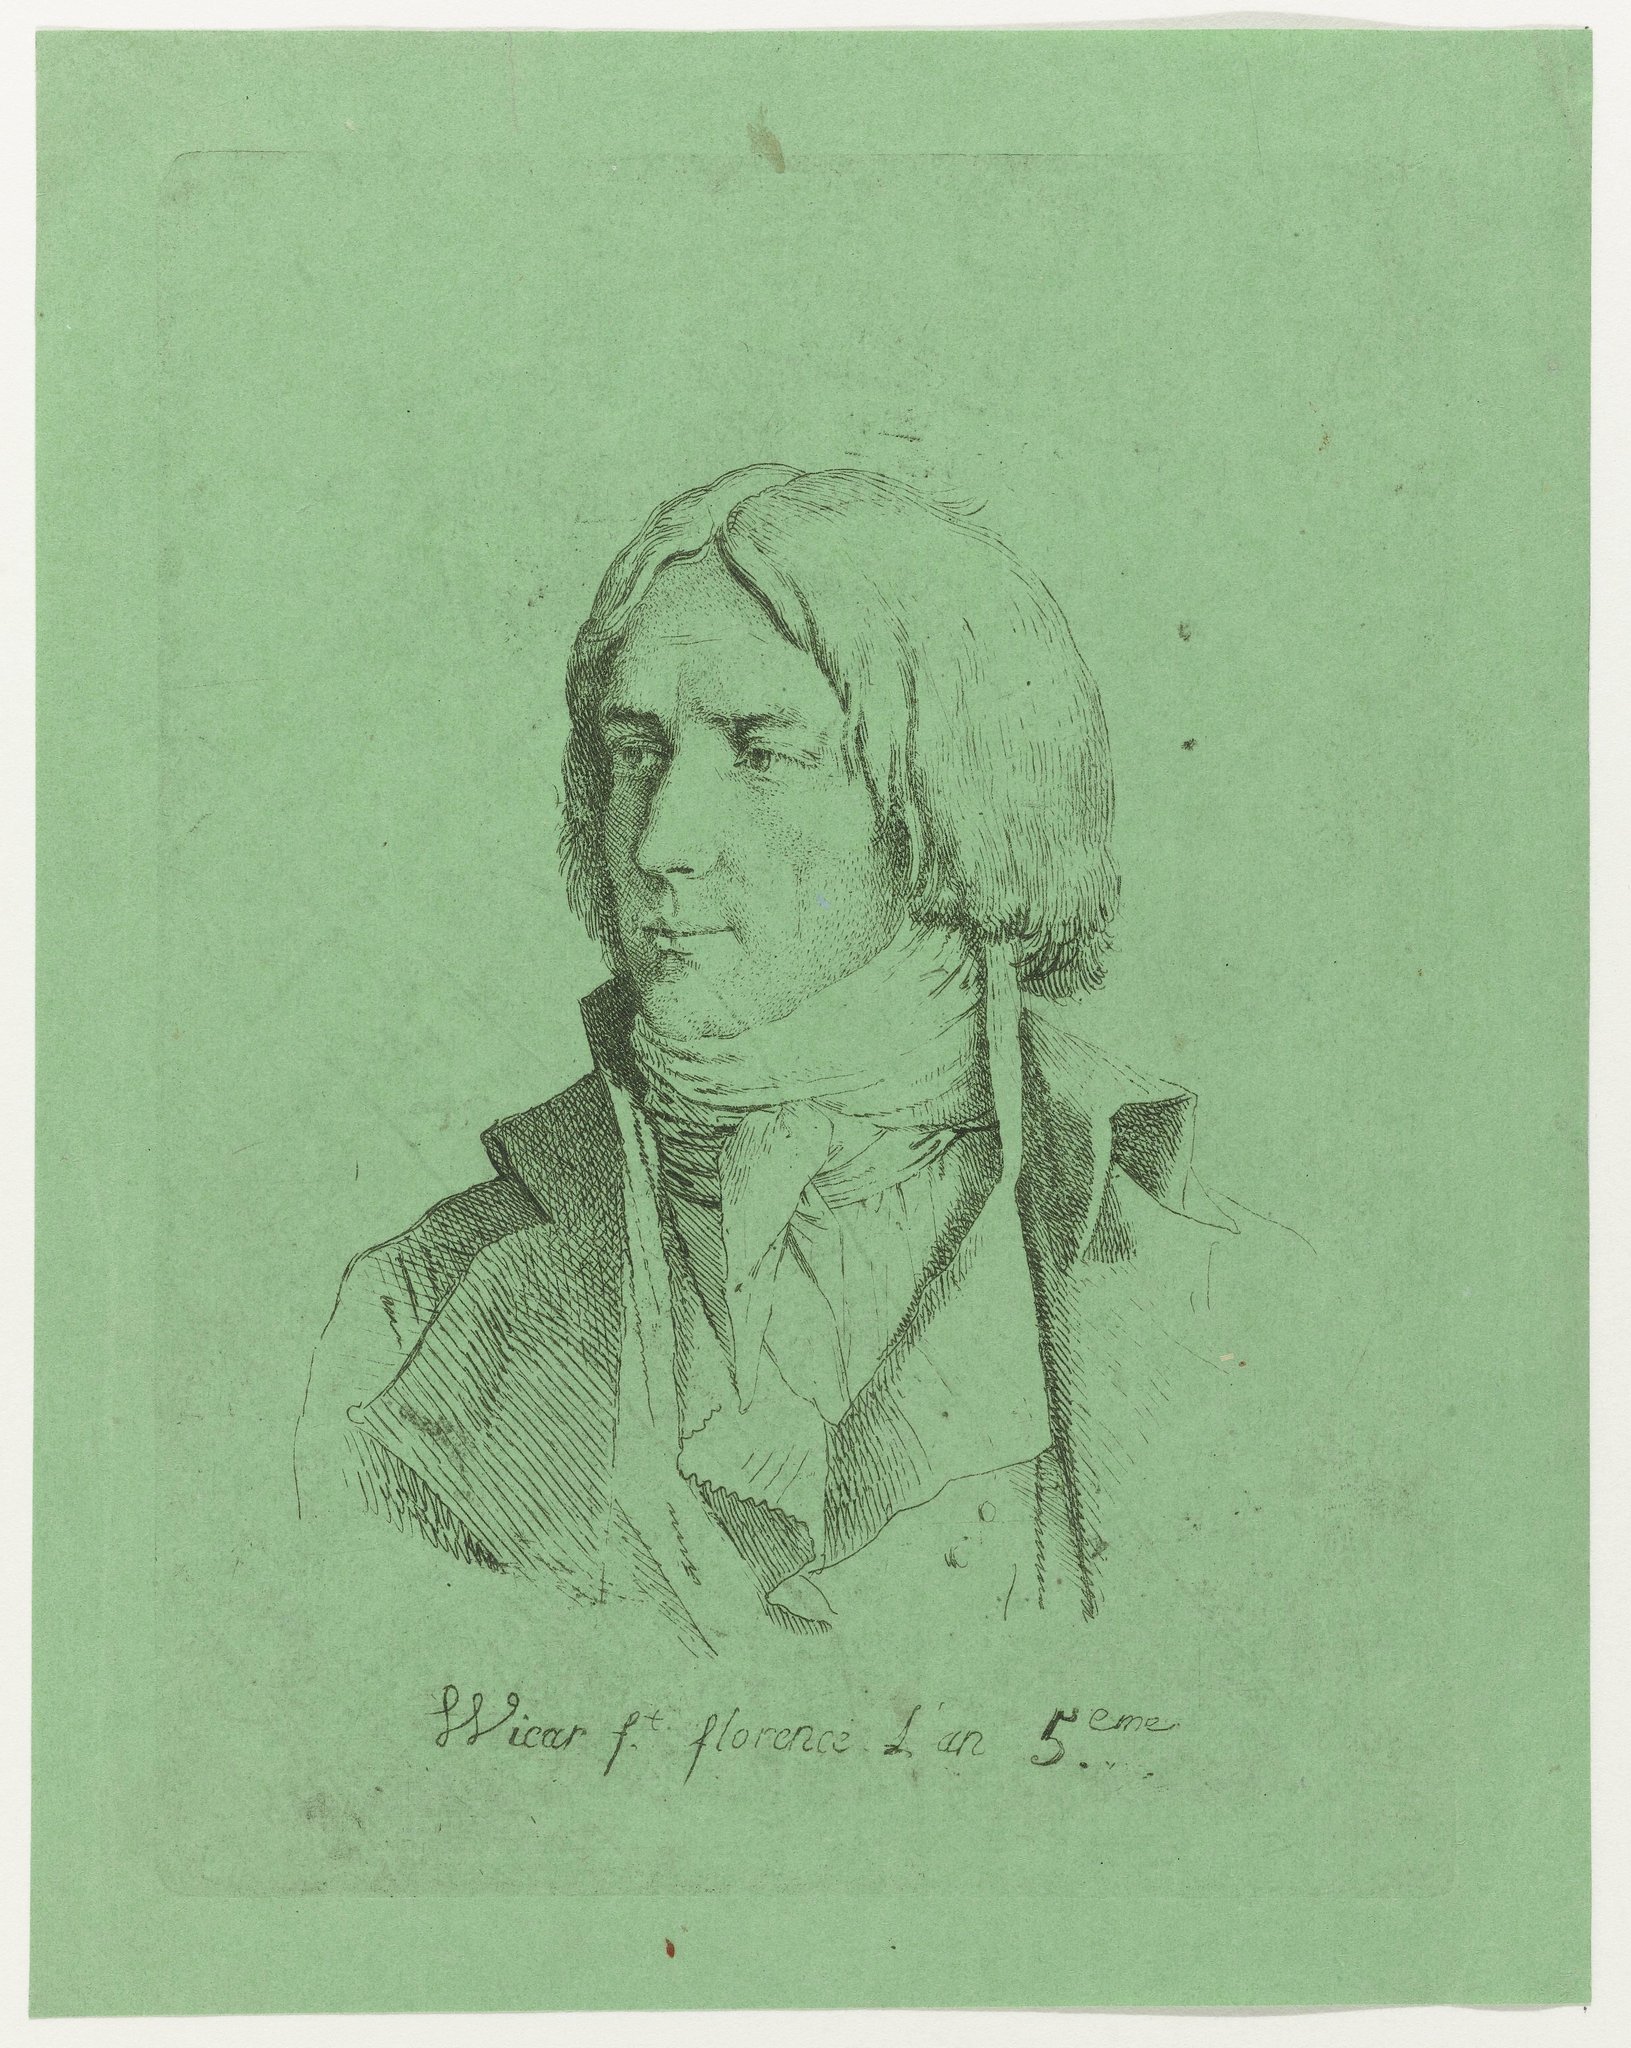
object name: print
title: Portret van een onbekende jongeman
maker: jean-baptiste joseph wicar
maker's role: draughtsman, painter, print maker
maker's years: 1762-1834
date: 1791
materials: paper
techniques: etching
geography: florence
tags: adult man (+ sideview, profile), portrait, self-portrait of artist, historical persons not known by name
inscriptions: collector's mark: Lugt 2760, date: ‘L'an 5 eme’, collector's mark: Lugt 2228, collector's mark: Lugt 5k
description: Buste van een jongeman, naar links kijkend. Mogelijk zelfportret.